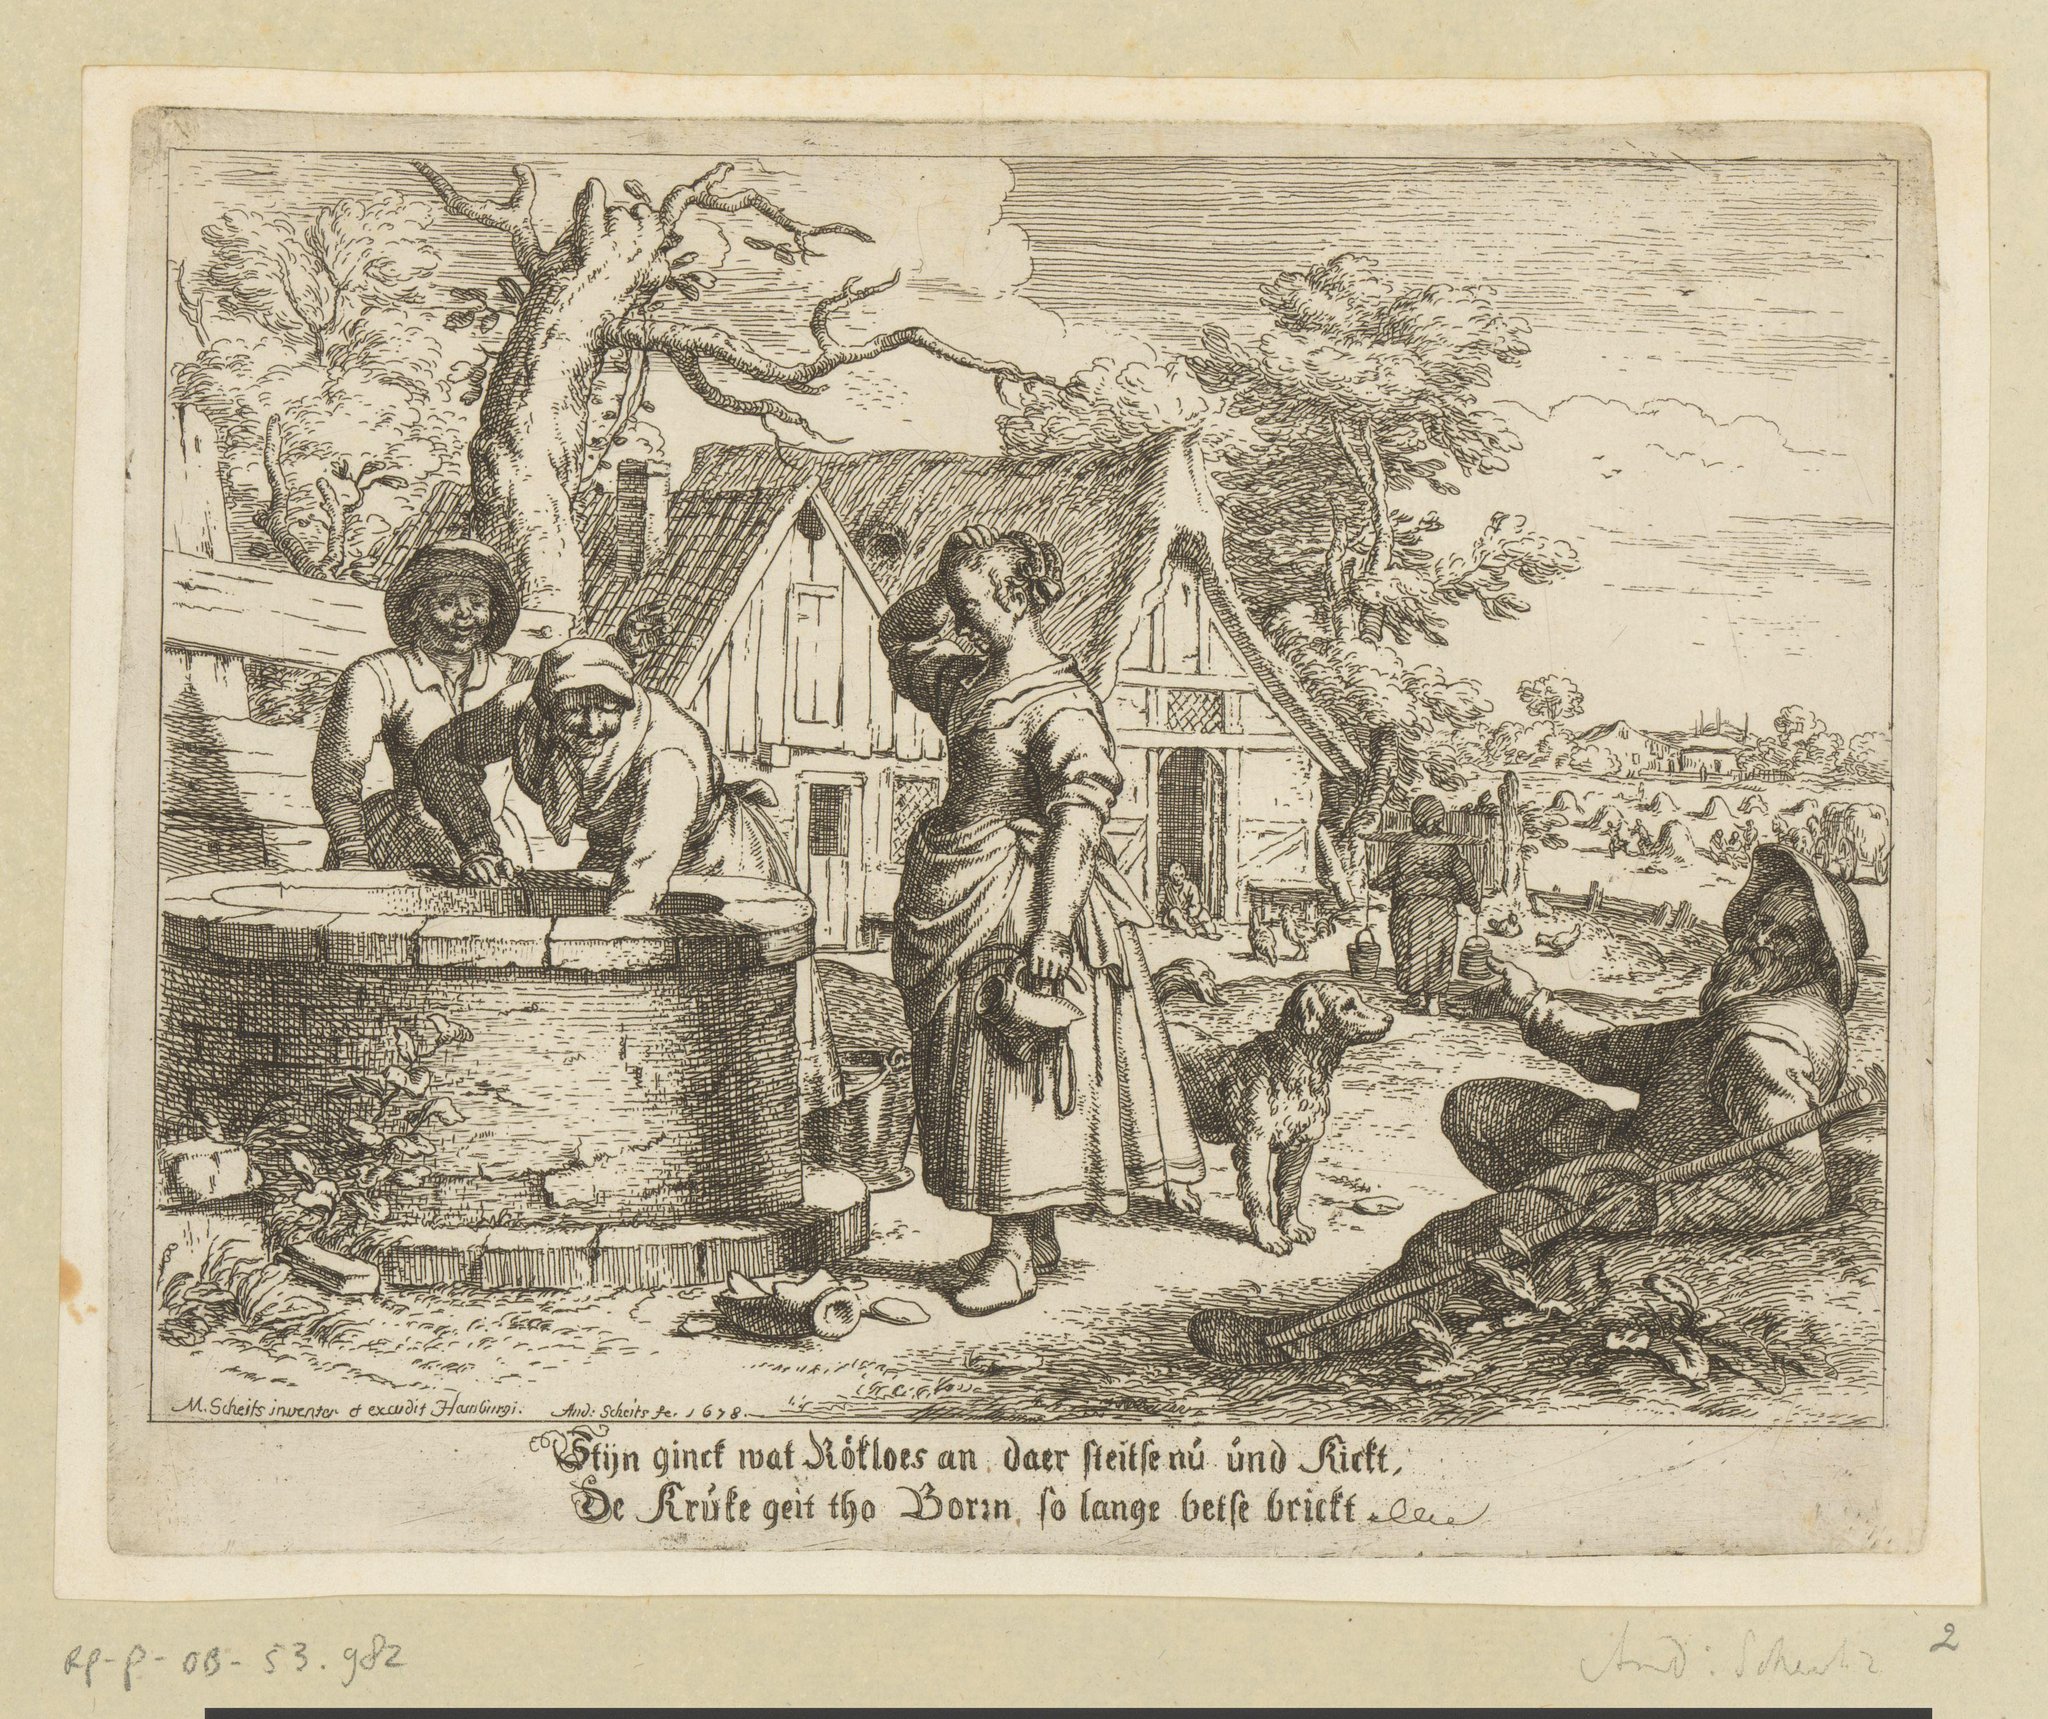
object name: print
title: Boeren bij een waterput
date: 1678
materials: paper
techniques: etching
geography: hamburg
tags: well, farmers, container of ceramics: jar, jug, pot, vase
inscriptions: collector's mark: Lugt 240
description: Moraliserende voorstelling met Nederduitse tekst over het halen van water uit een bron met een kapotte kruik.